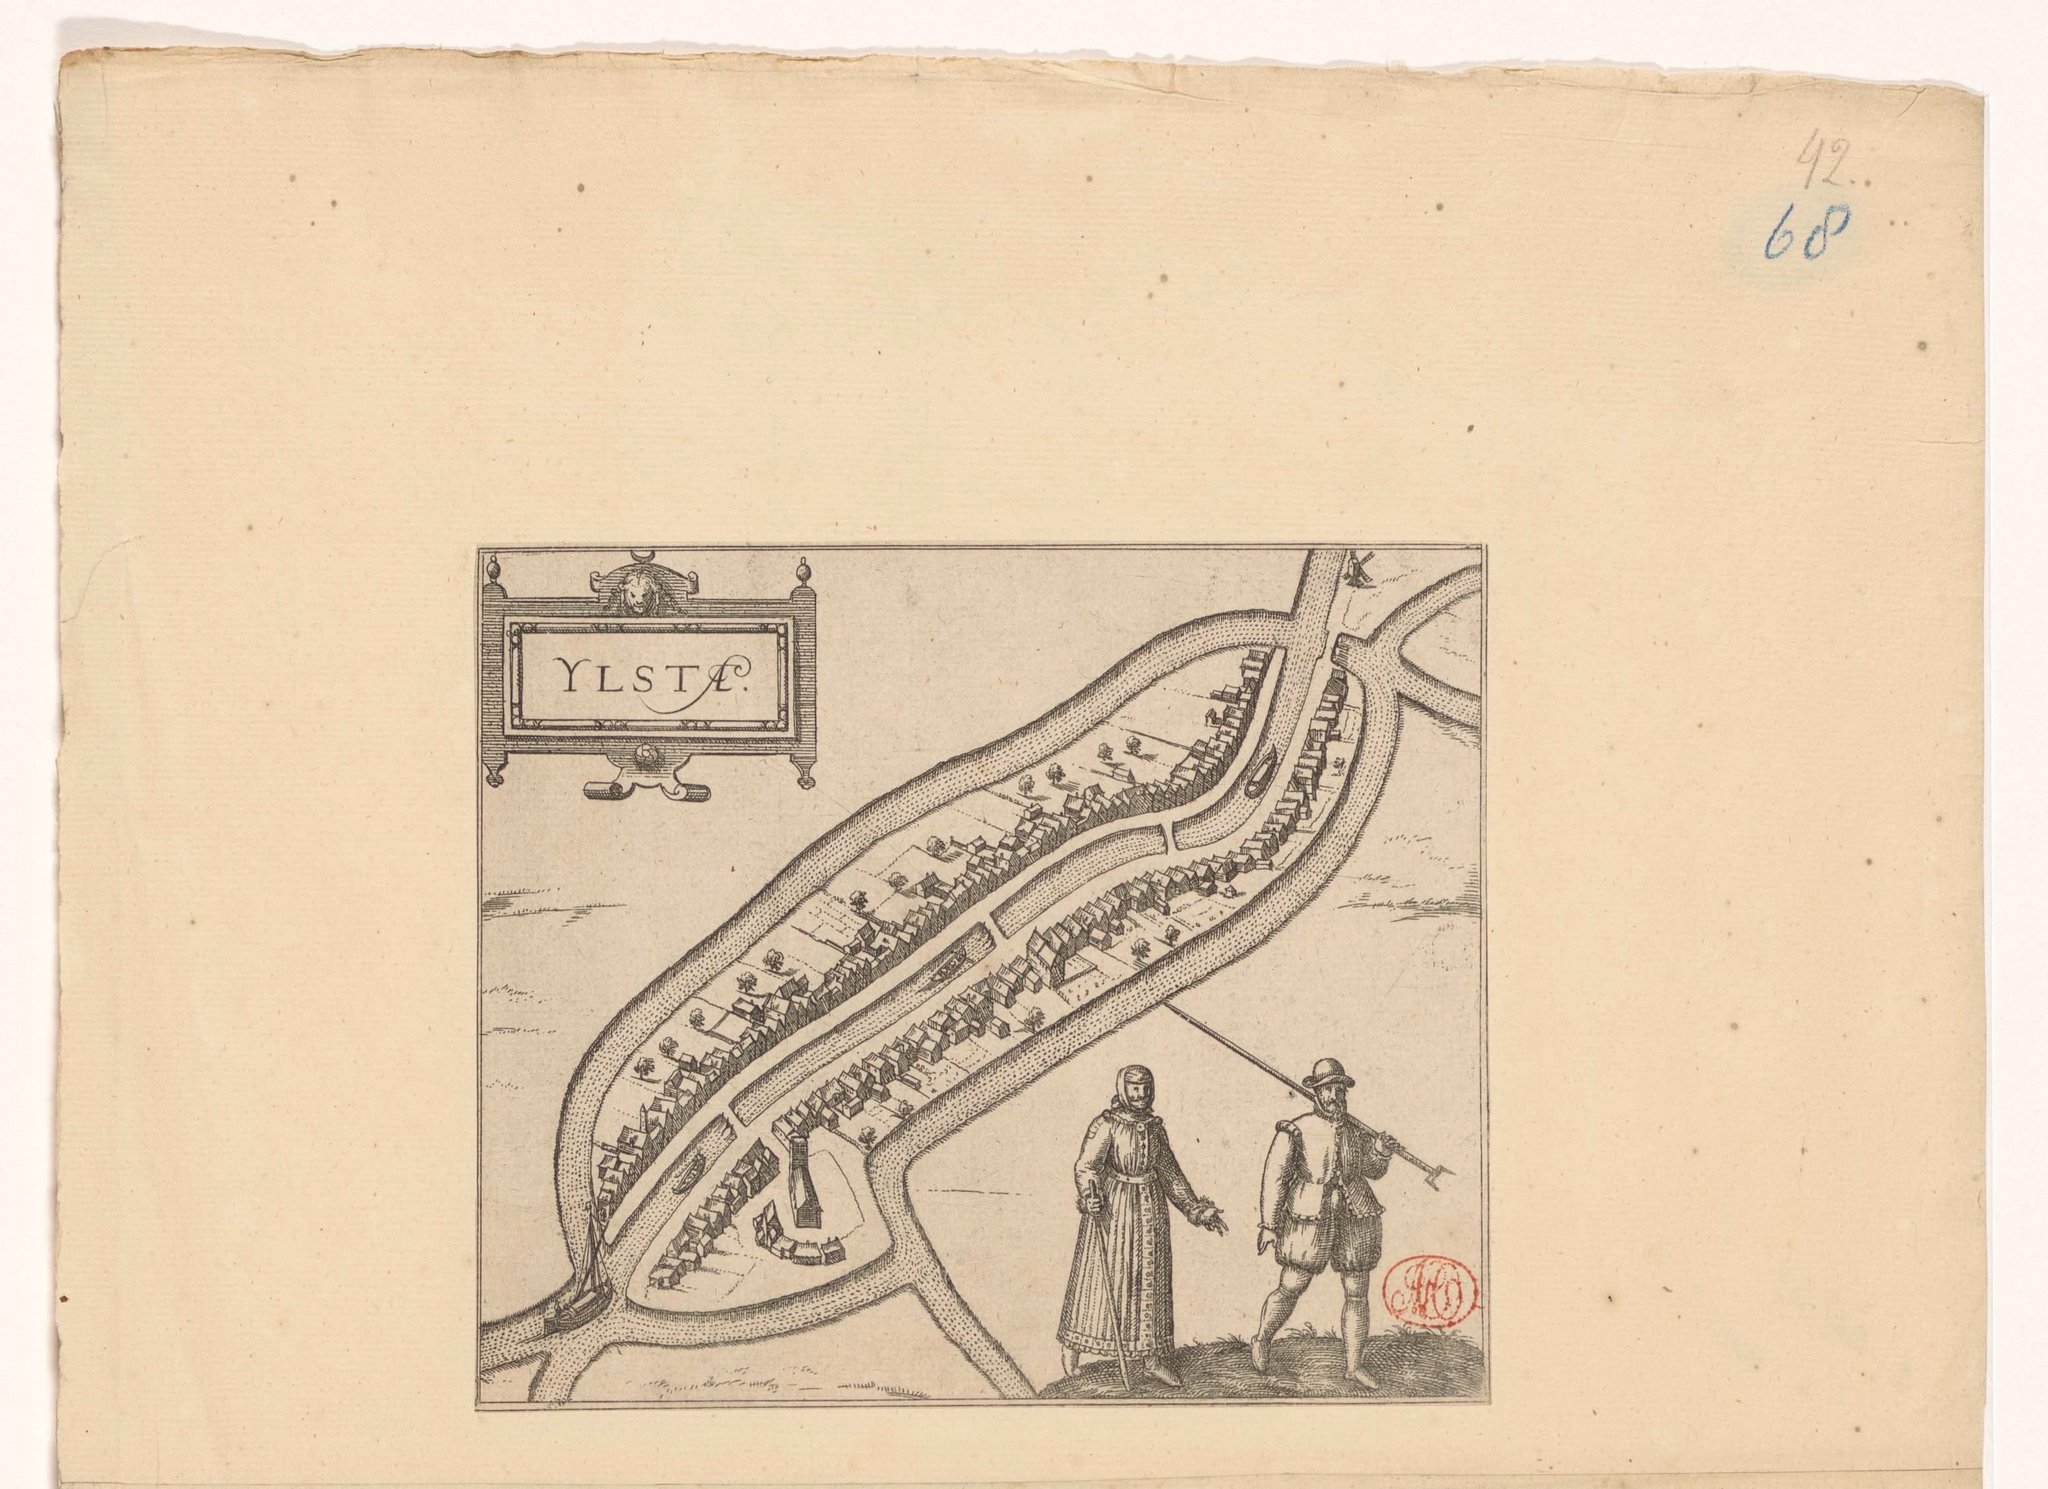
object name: print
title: Plattegrond van IJlst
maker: Anonymous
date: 1550-1650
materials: paper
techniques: etching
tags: folk costume, regional costume, maps of cities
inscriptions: label: ‘264’, collector's mark: Lugt 195, collector's mark: Lugt 2228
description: Plattegrond van IJlst in vogelvluchtperspectief. Linksboven titel, rechtsonder een man en een vrouw.